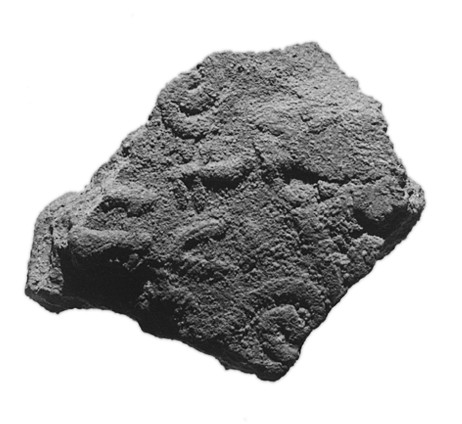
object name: sealing fragment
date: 2030-1640 BCE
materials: clay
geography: egypt